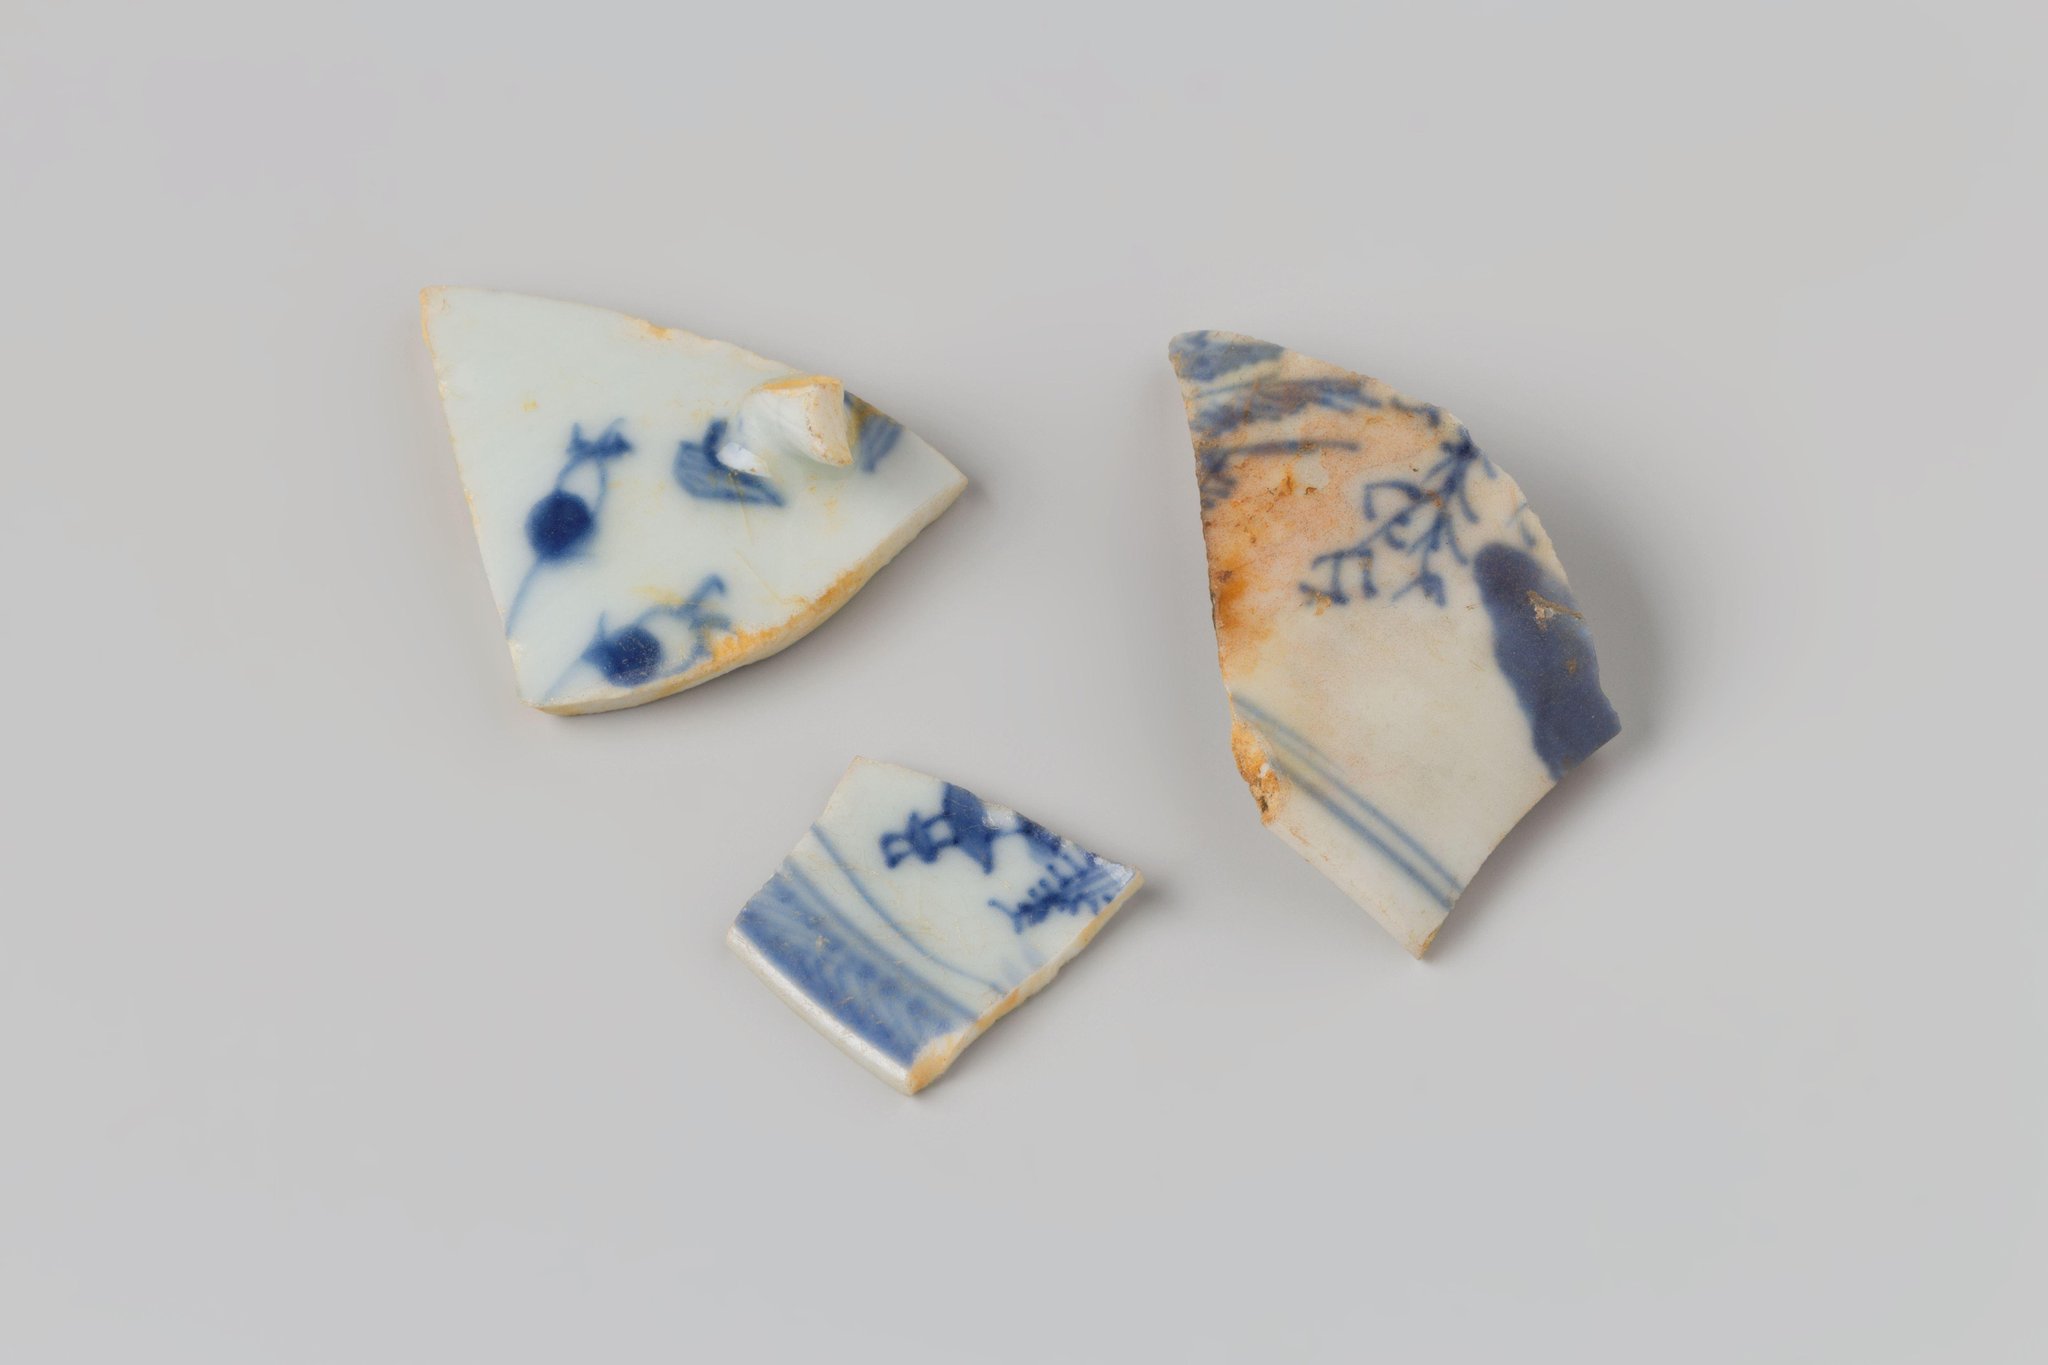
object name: sherd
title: Scherven van een kop uit het wrak van de Oost-Indiëvaarder Hollandia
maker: Anonymous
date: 1700-1743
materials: porcelain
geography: netherlands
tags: verenigde oostindische compagnie, hollandia (schip), annet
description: Porcelain, cup, type 3; fragm of body, sim. NG 1980-27H916.